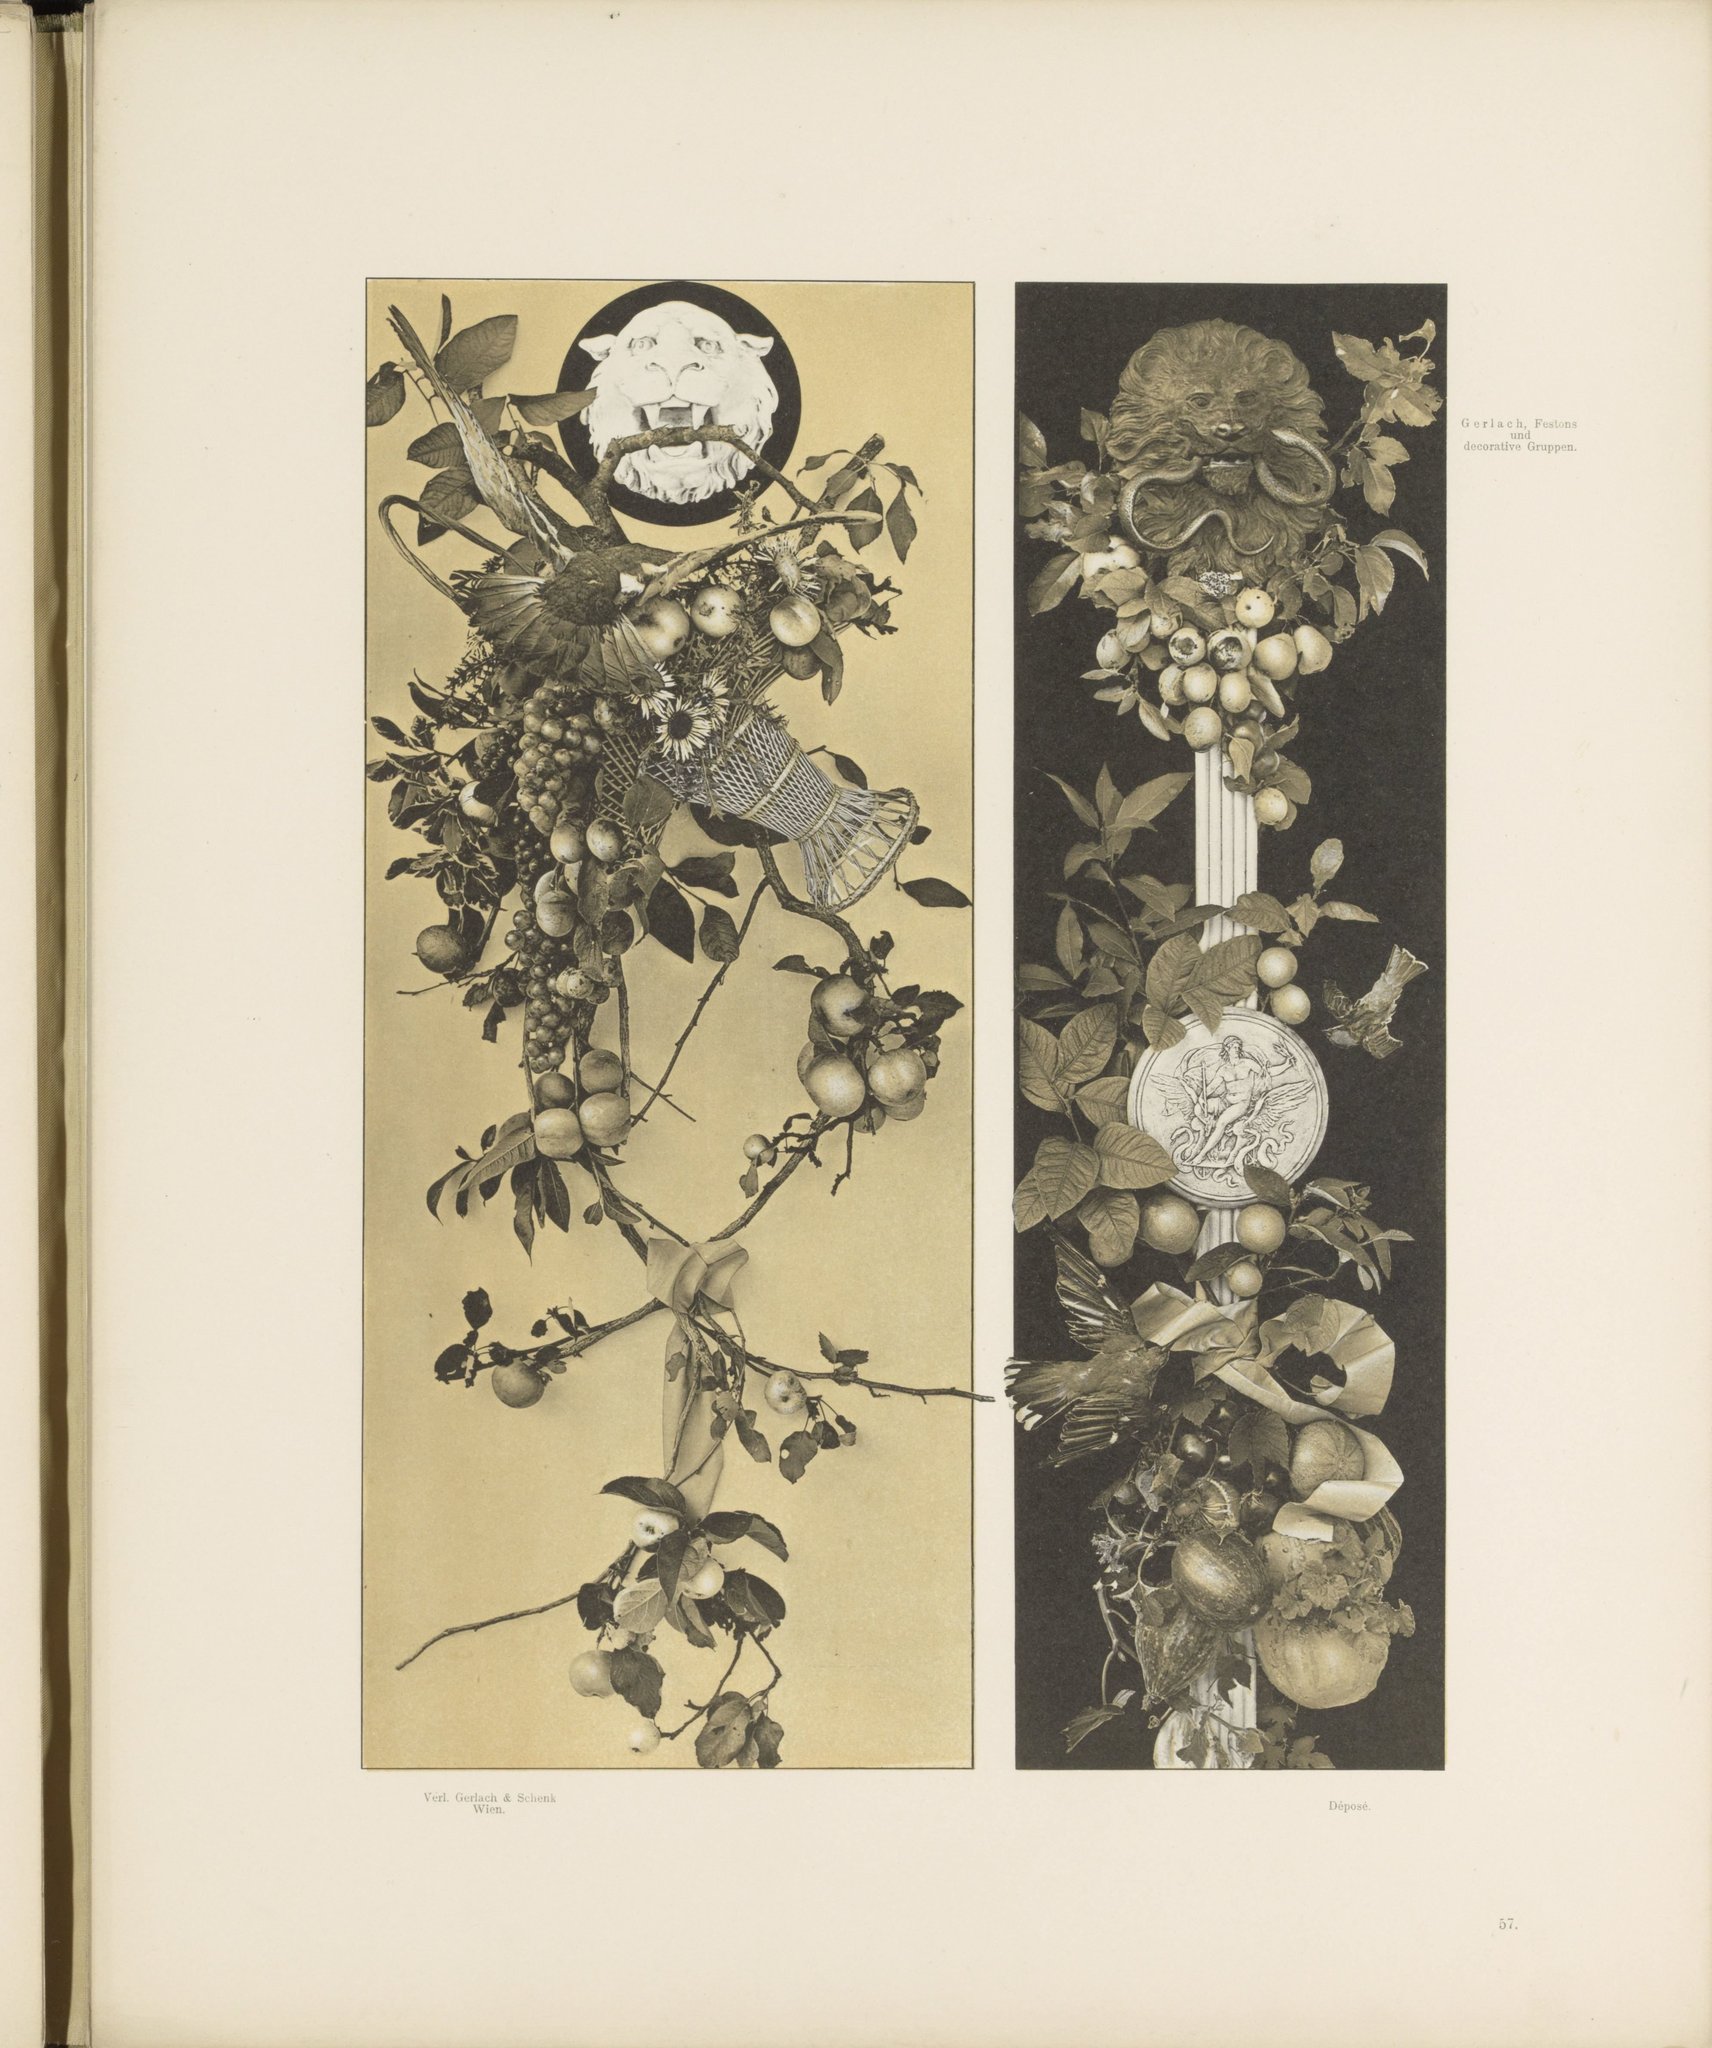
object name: photomechanical print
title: Hangwerk van appels en een leeuwenkop en een festoen van pompoenen en een medaillon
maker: Anonymous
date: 1887-1897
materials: paper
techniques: photograph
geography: austria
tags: lion's head ~ ornament, ornament ~ medallion, ornament ~ festoon, garland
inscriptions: number: ‘57.’